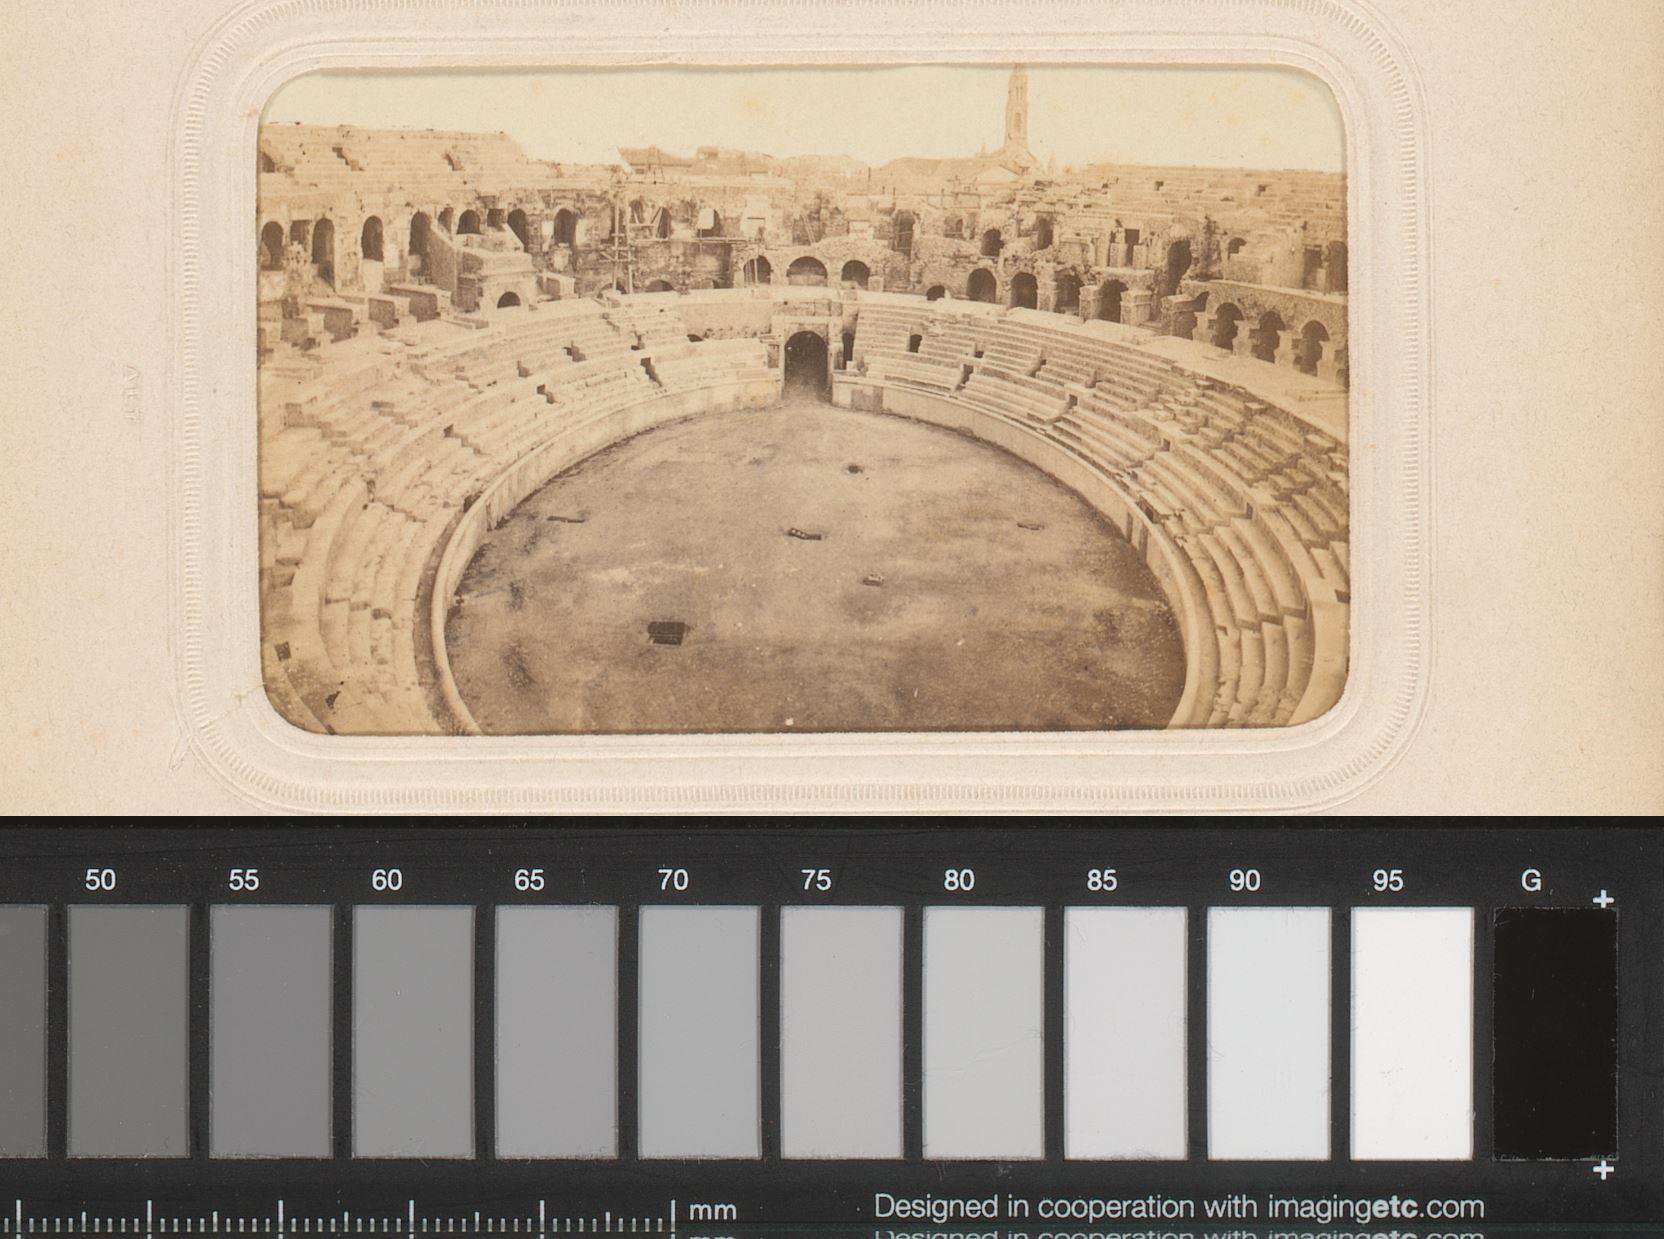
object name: photograph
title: Gezicht op een amfitheater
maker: Anonymous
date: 1860-1900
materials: cardboard, photographic support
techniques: albumen print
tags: amphitheatre